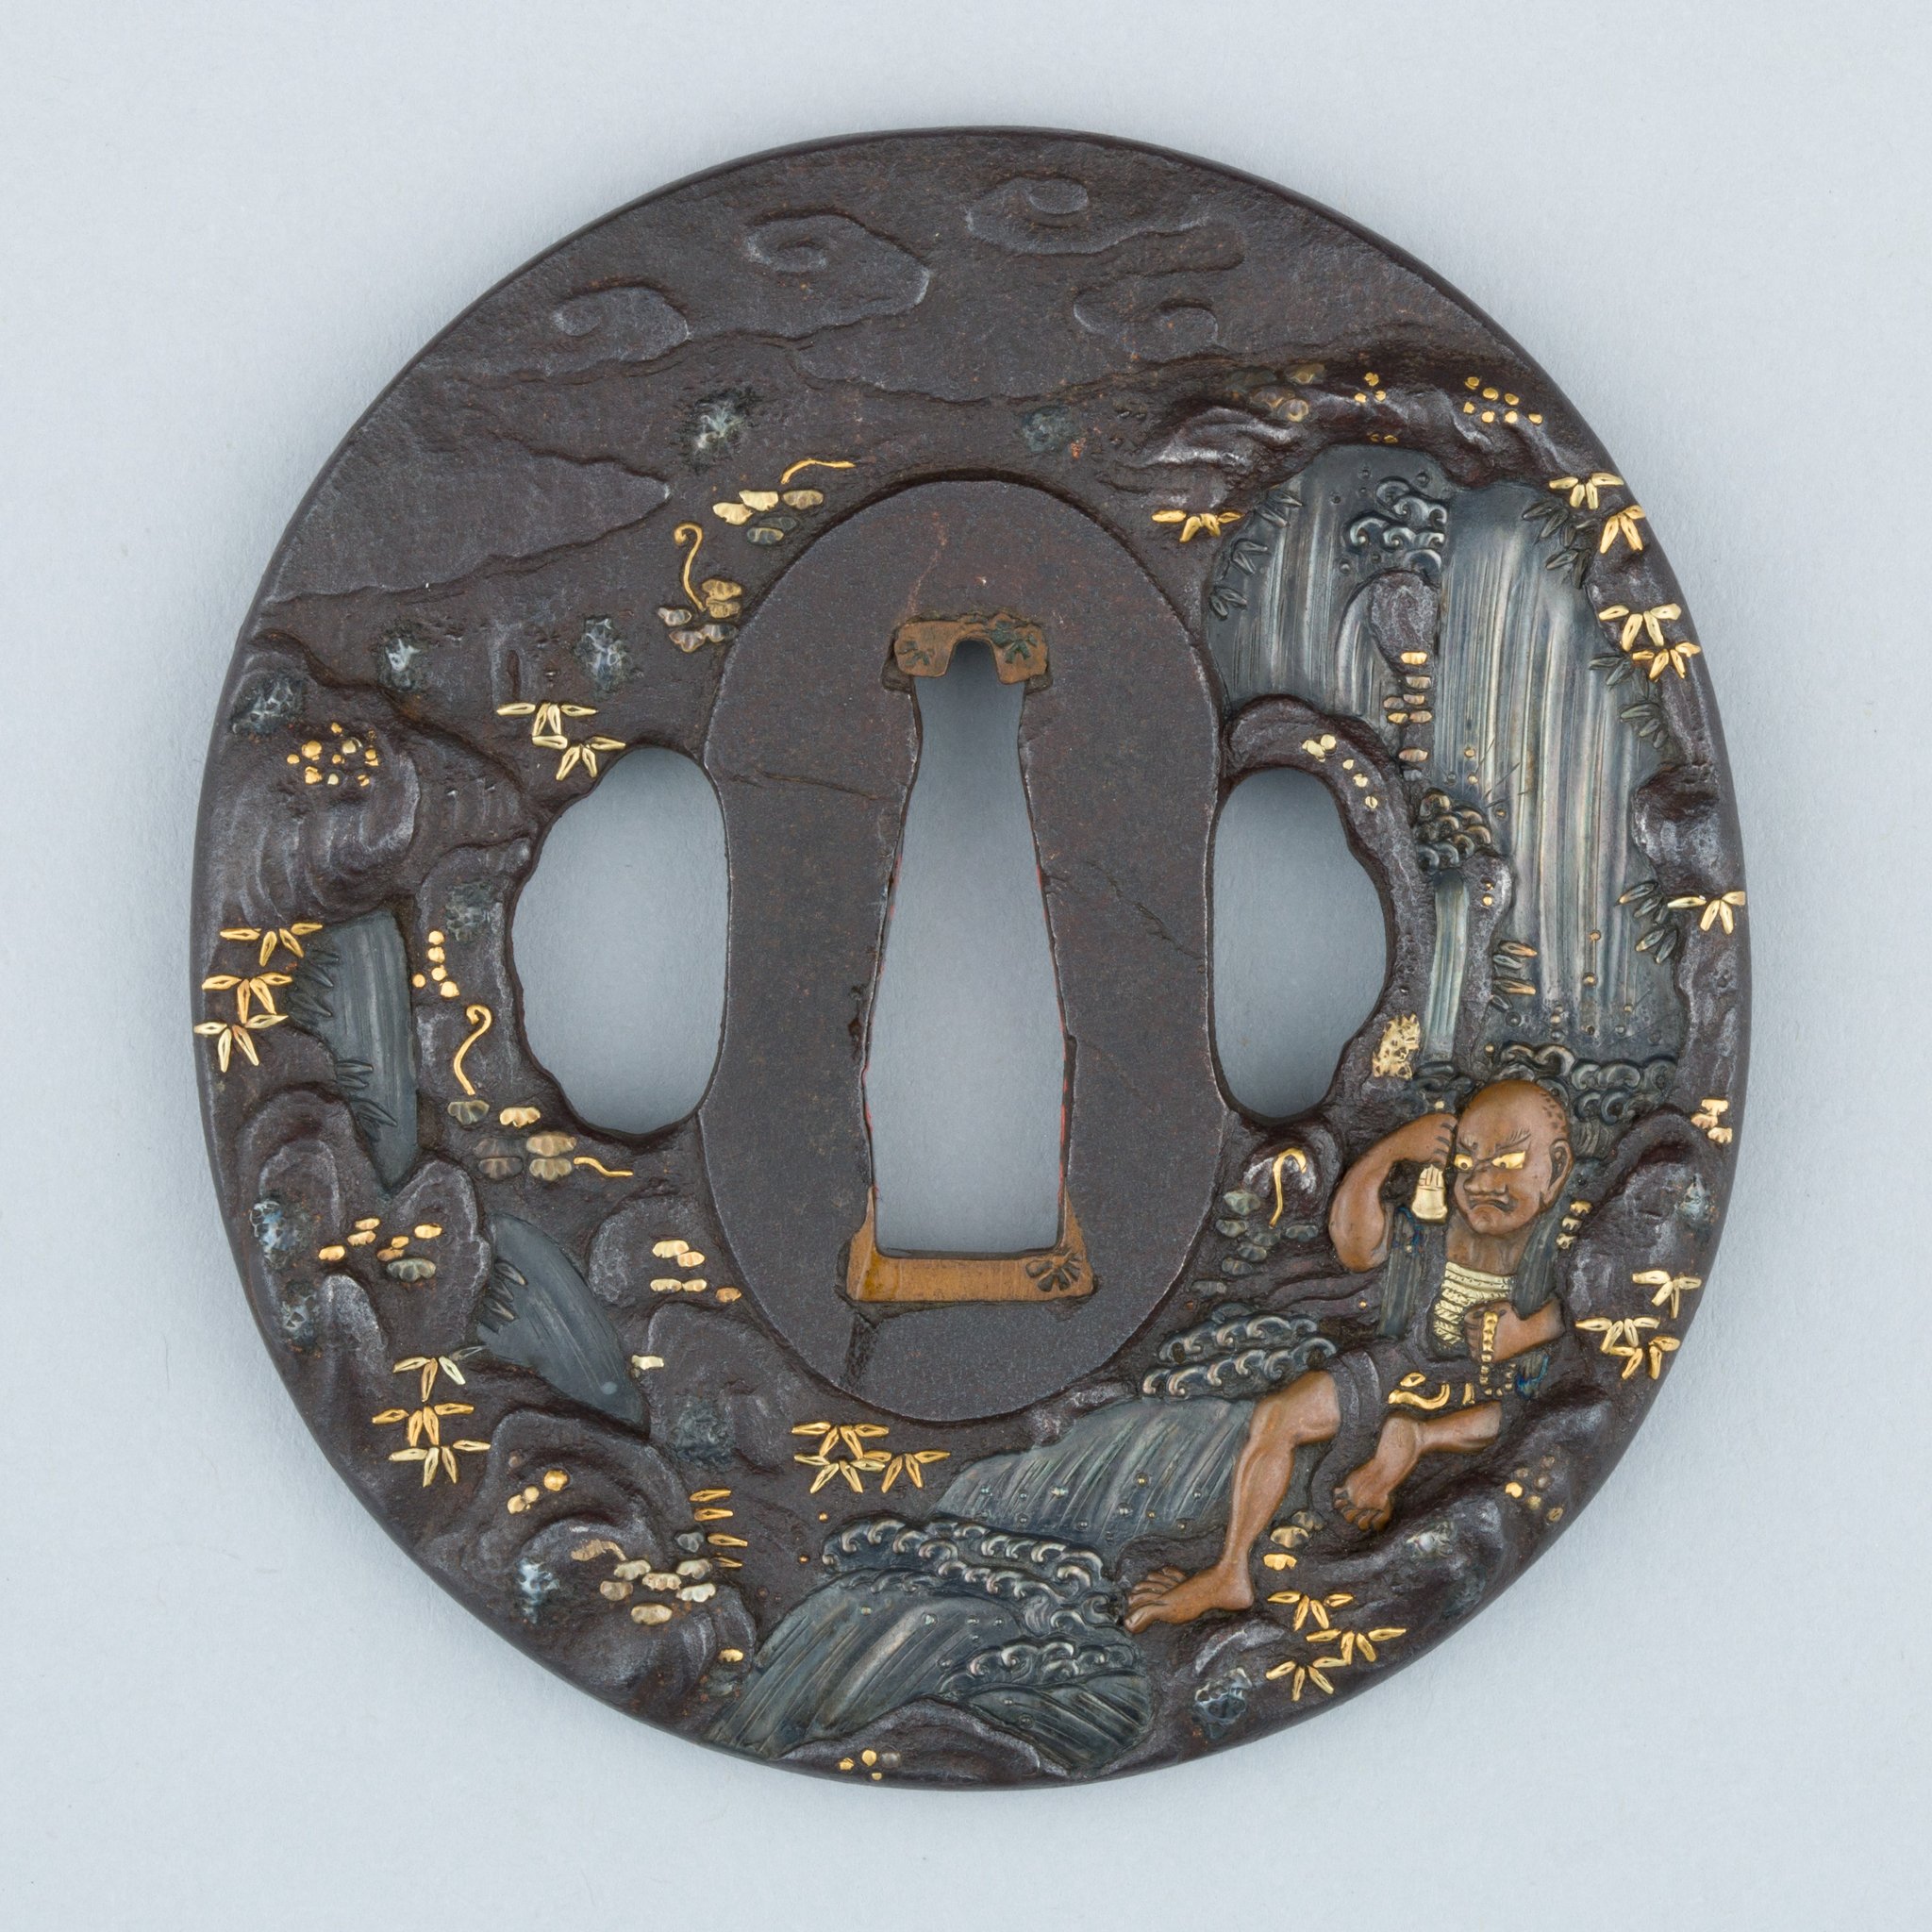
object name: sword guard tsuba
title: Sword Guard (Tsuba)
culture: japanese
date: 1834-1866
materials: copper, gold, iron, silver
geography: japan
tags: men